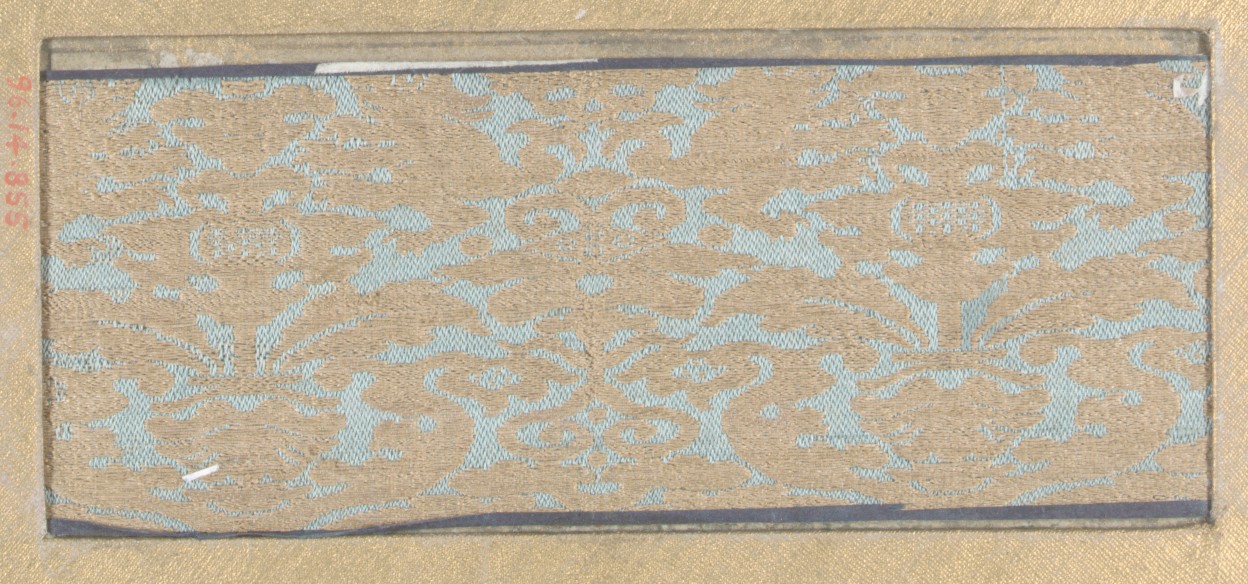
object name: piece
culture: japanese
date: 1701-1900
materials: silk